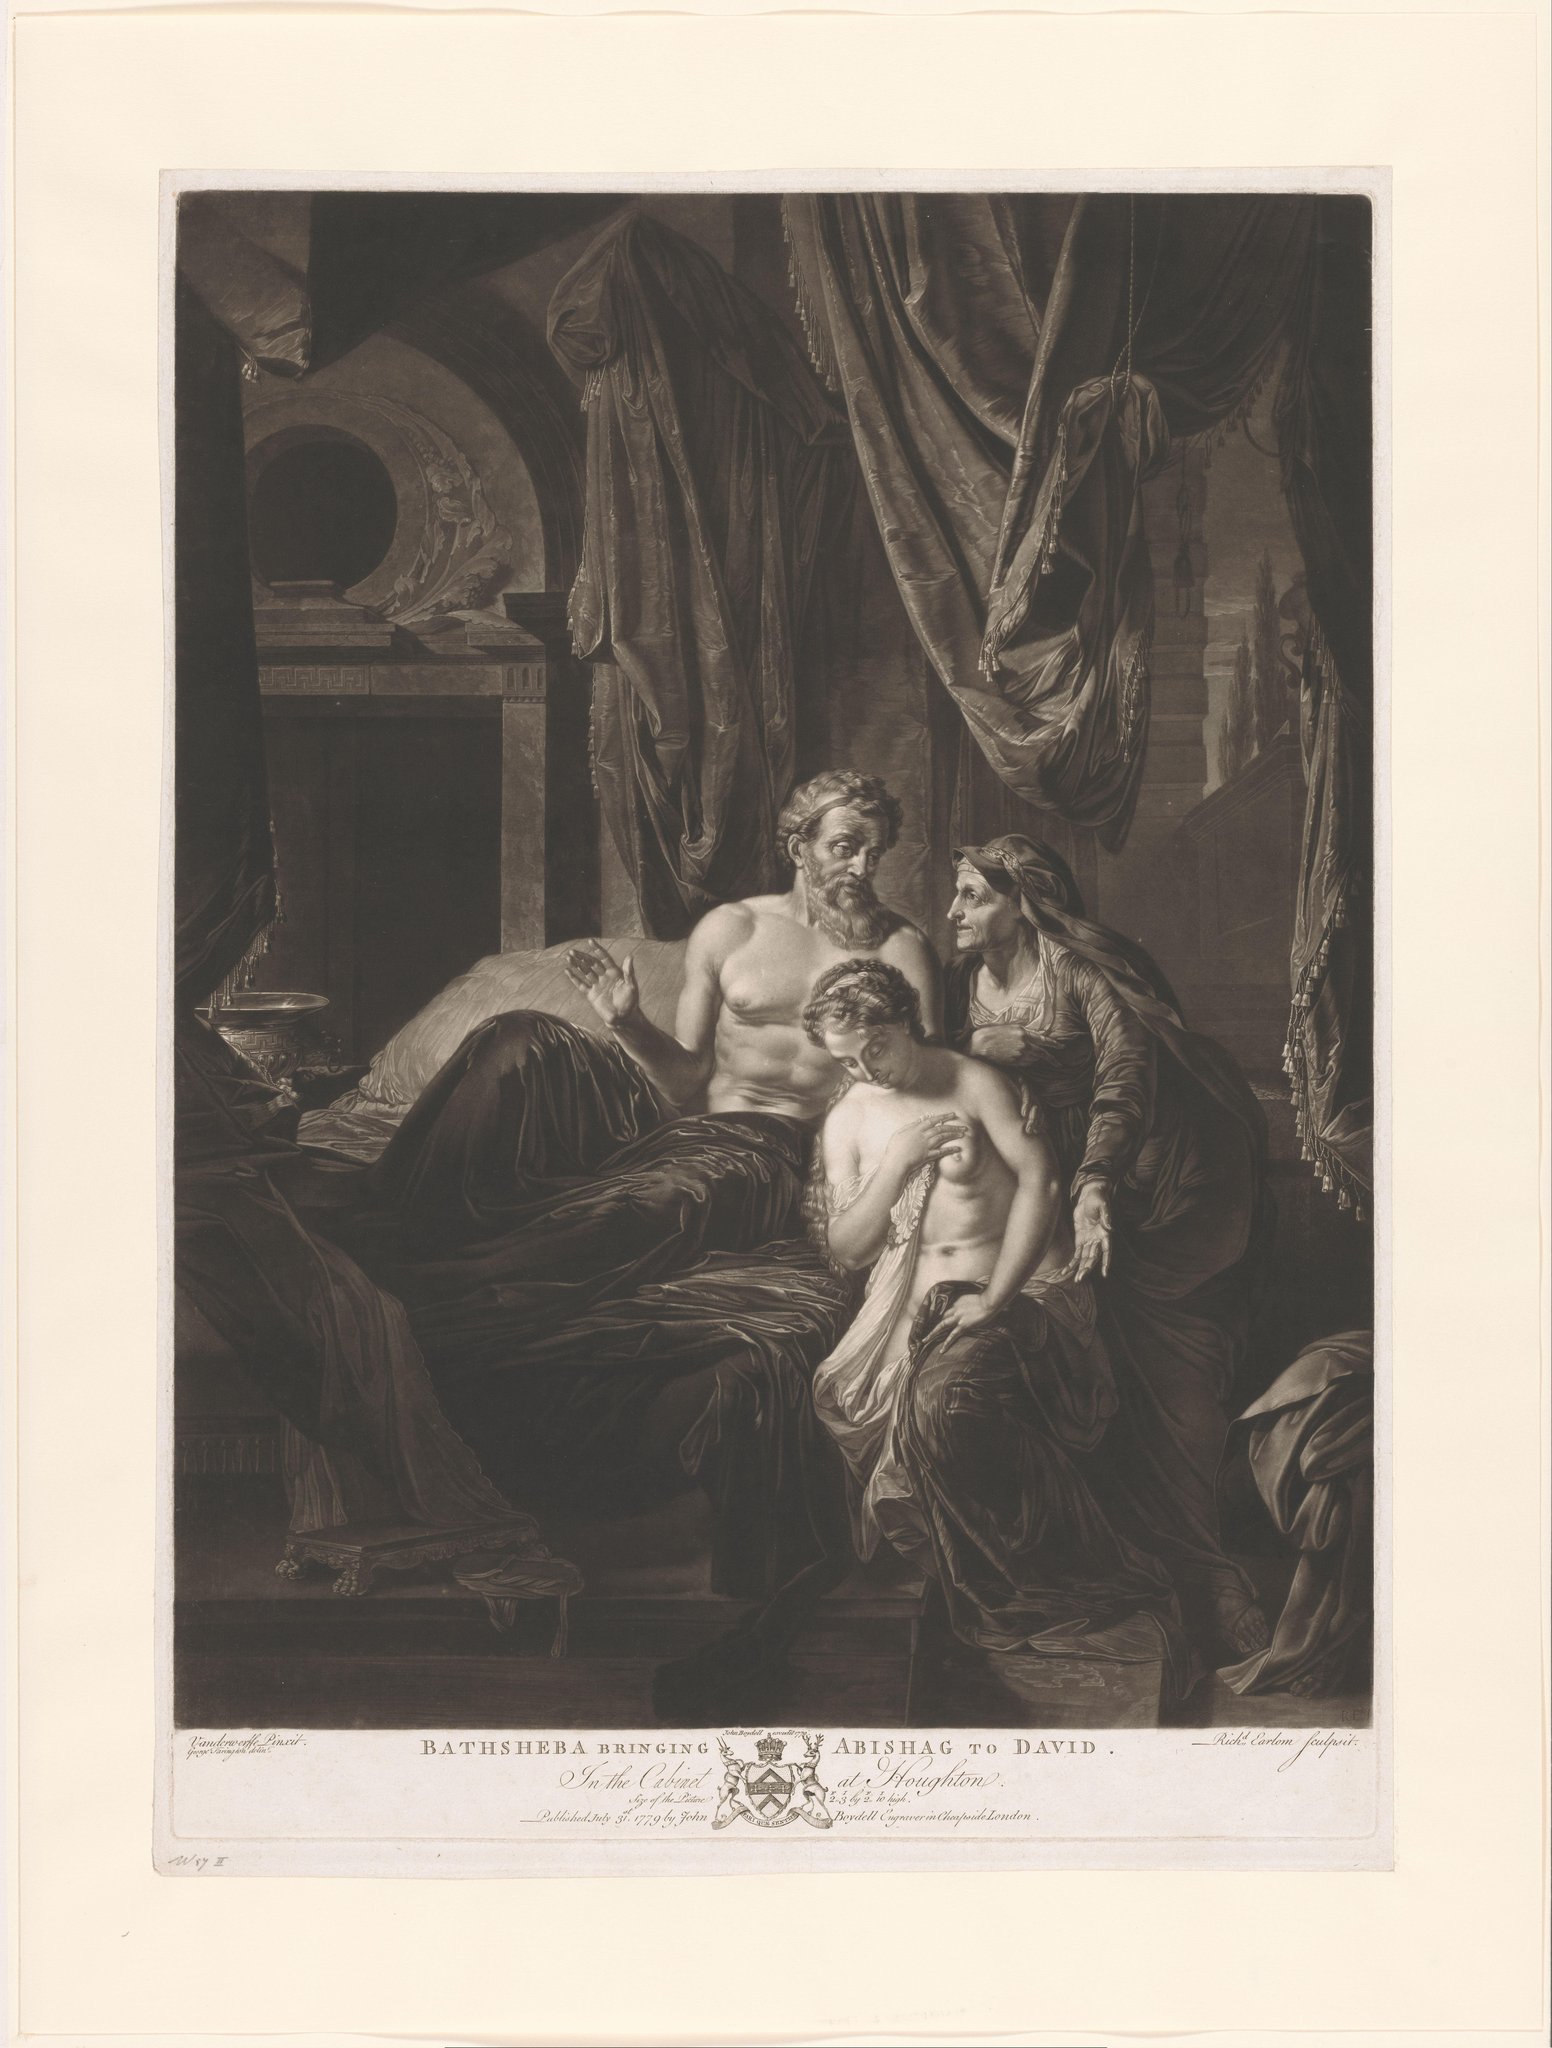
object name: print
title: Bathseba brengt Abisag bij David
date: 1779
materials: paper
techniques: engraving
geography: london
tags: adoniah comes to bathsheba asking for help in order to get abishag as wife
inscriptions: collector's mark: Lugt 2228